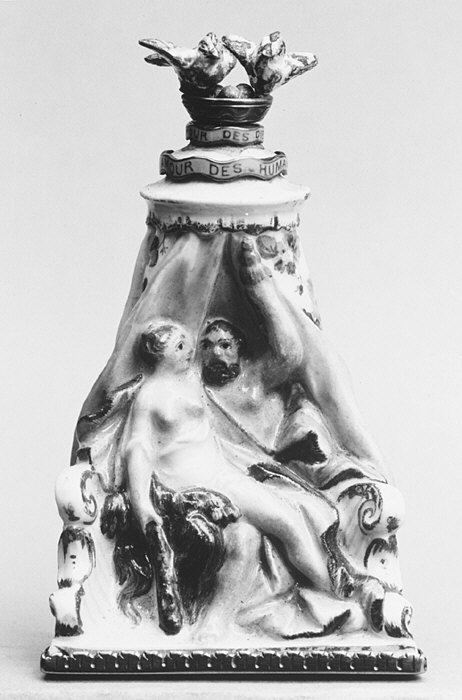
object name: scent bottle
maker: meissen manufactory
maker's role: manufactory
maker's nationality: german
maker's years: 1710-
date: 1770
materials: porcelain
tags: birds,men,women